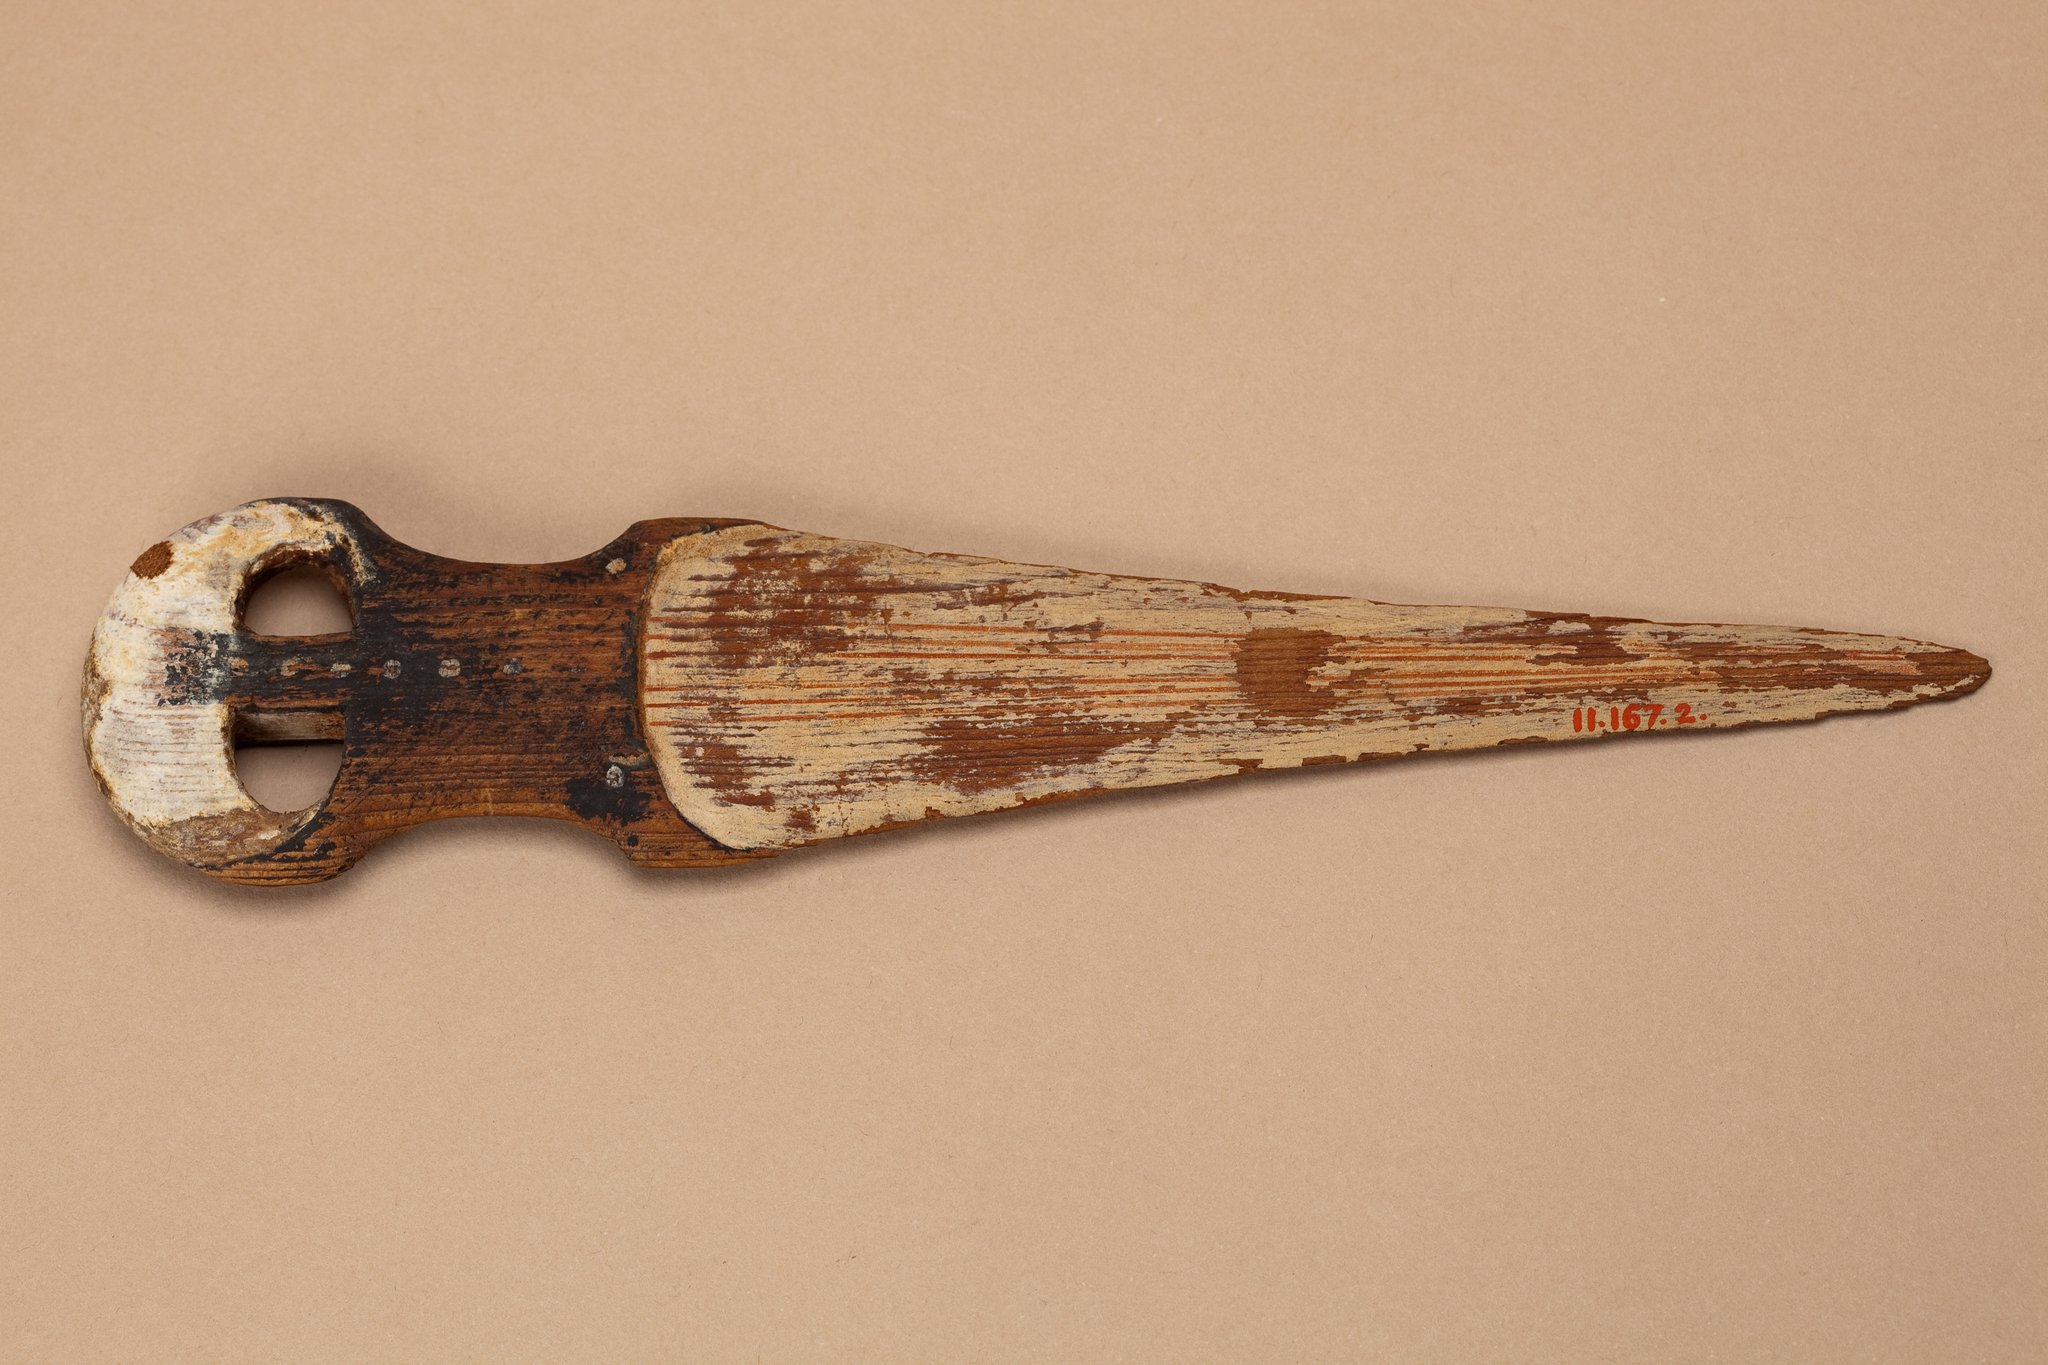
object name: model dagger, ukhhotep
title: Model dagger of Ukhhotep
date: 1981-1802 BCE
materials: gold leaf, paint, wood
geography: egypt